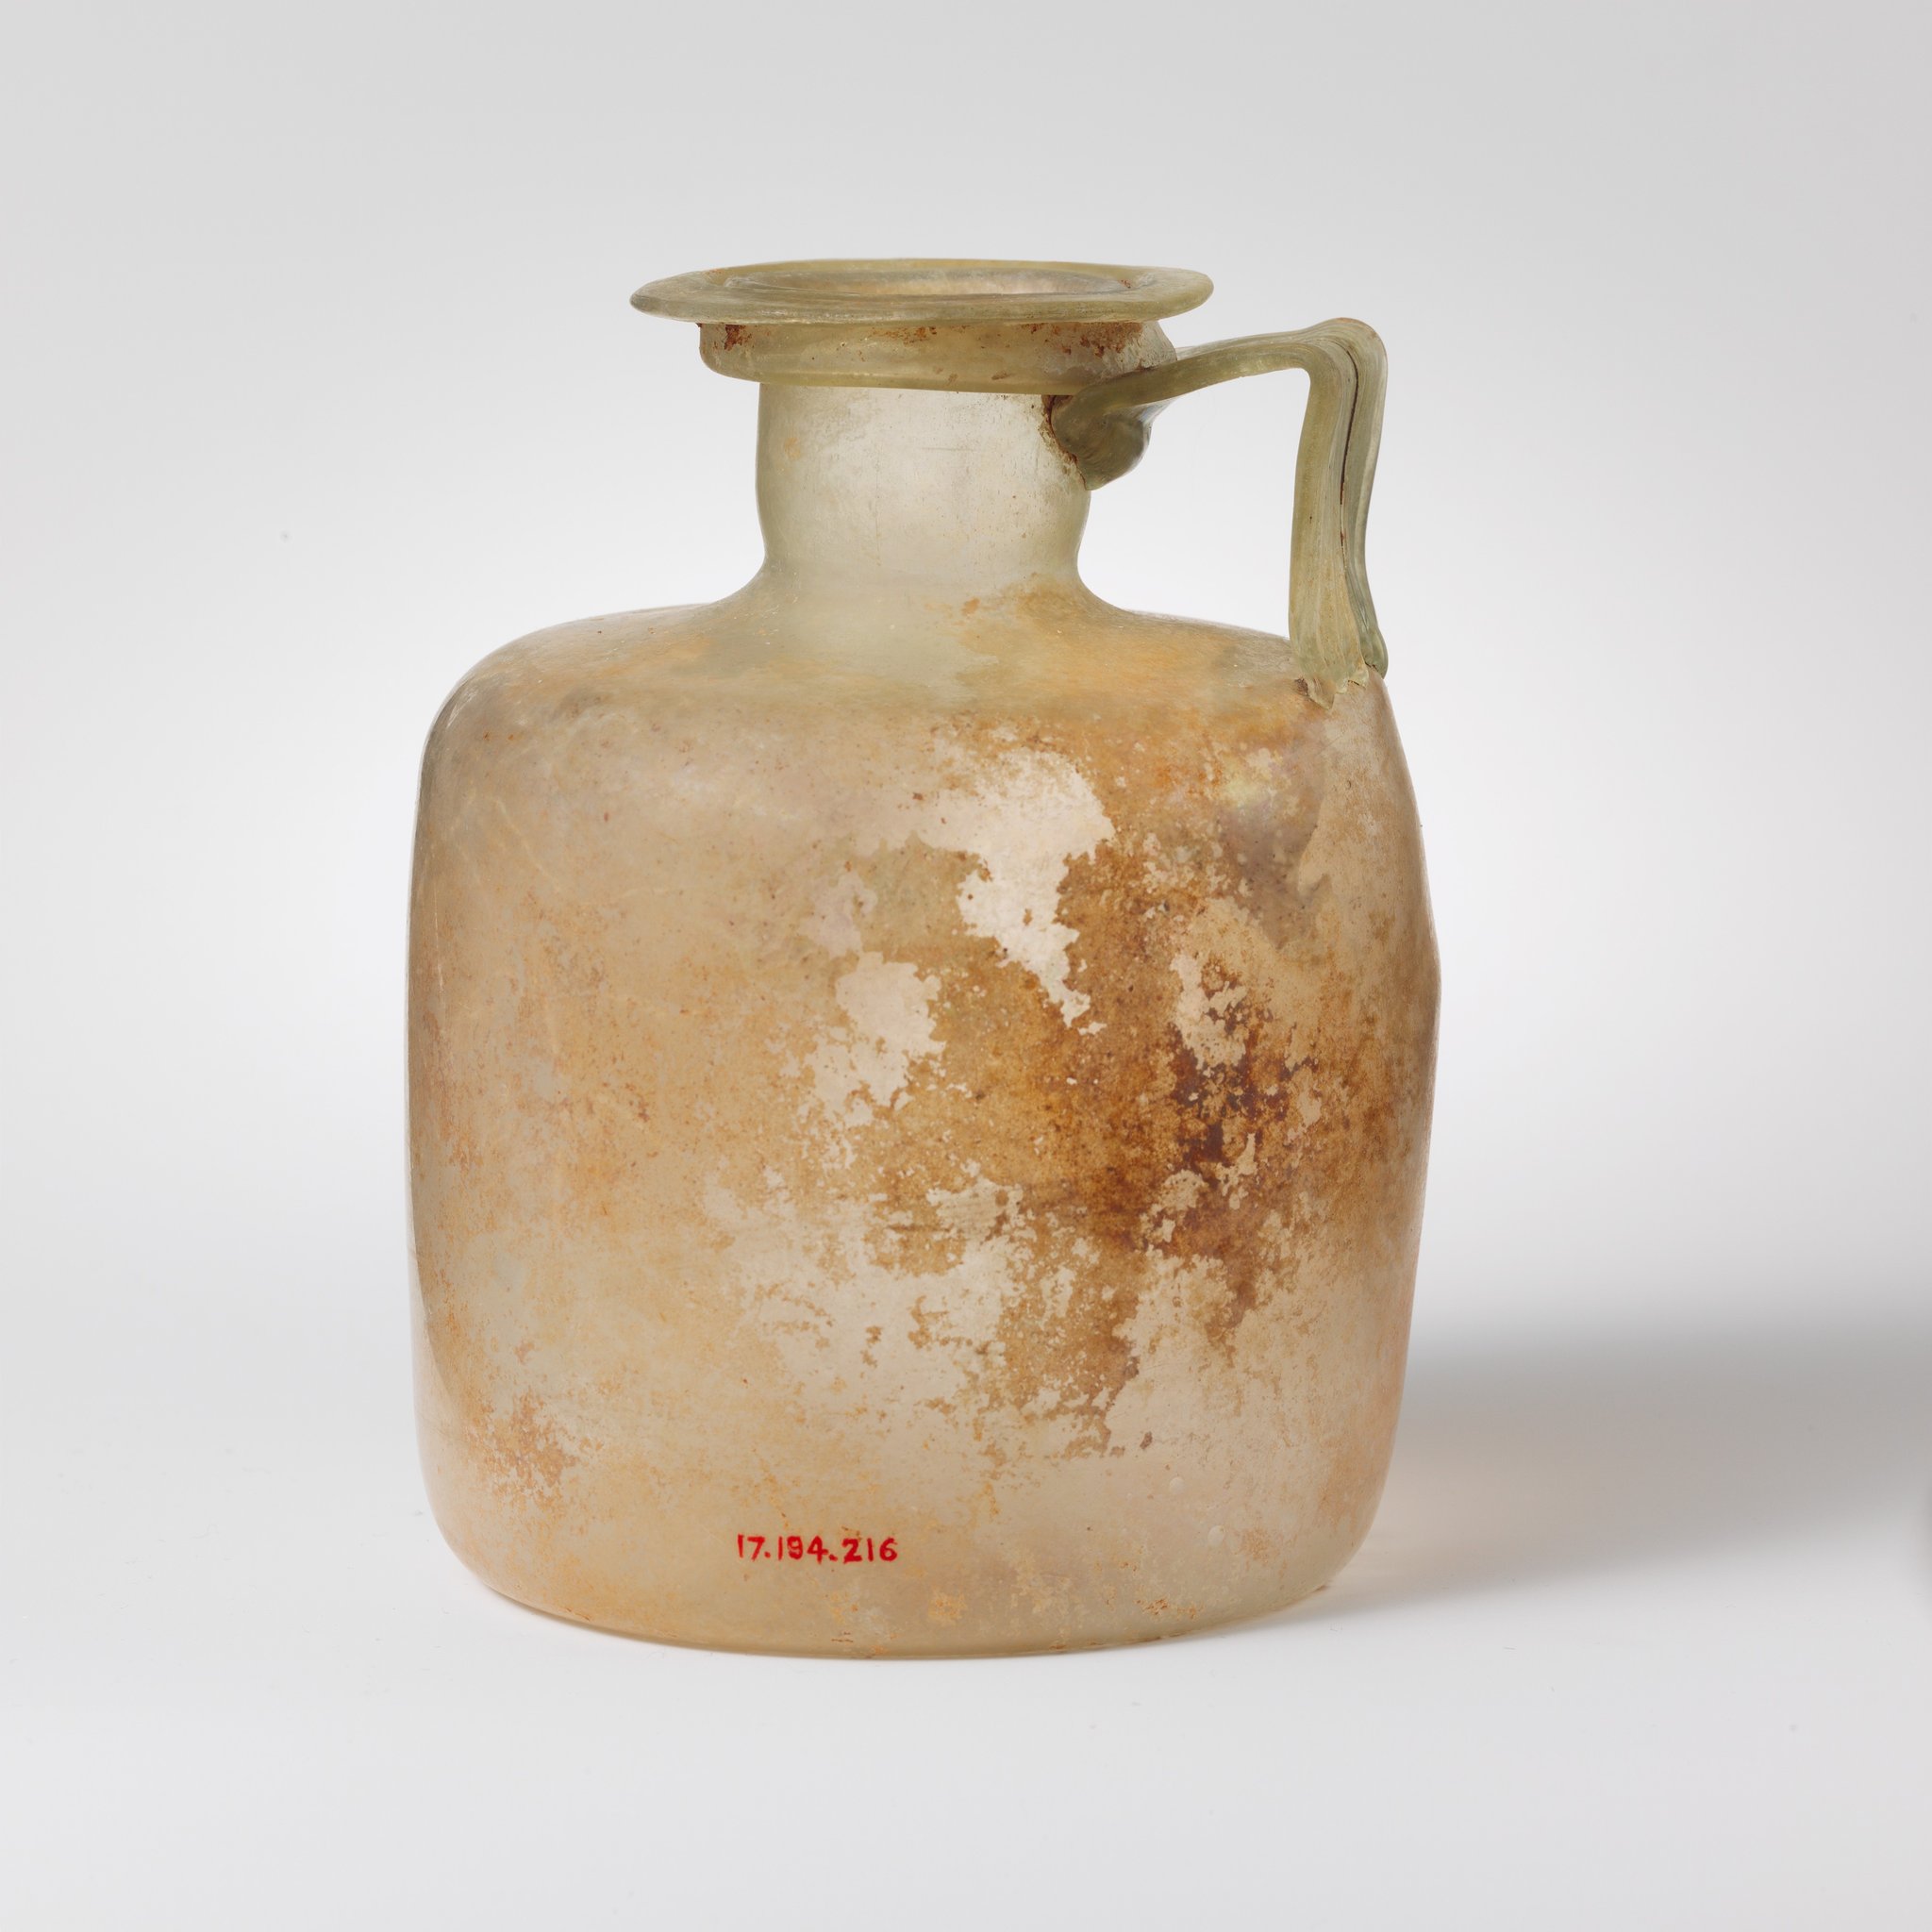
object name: bottle, two handled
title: Glass one-handled bottle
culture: roman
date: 1-200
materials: glass